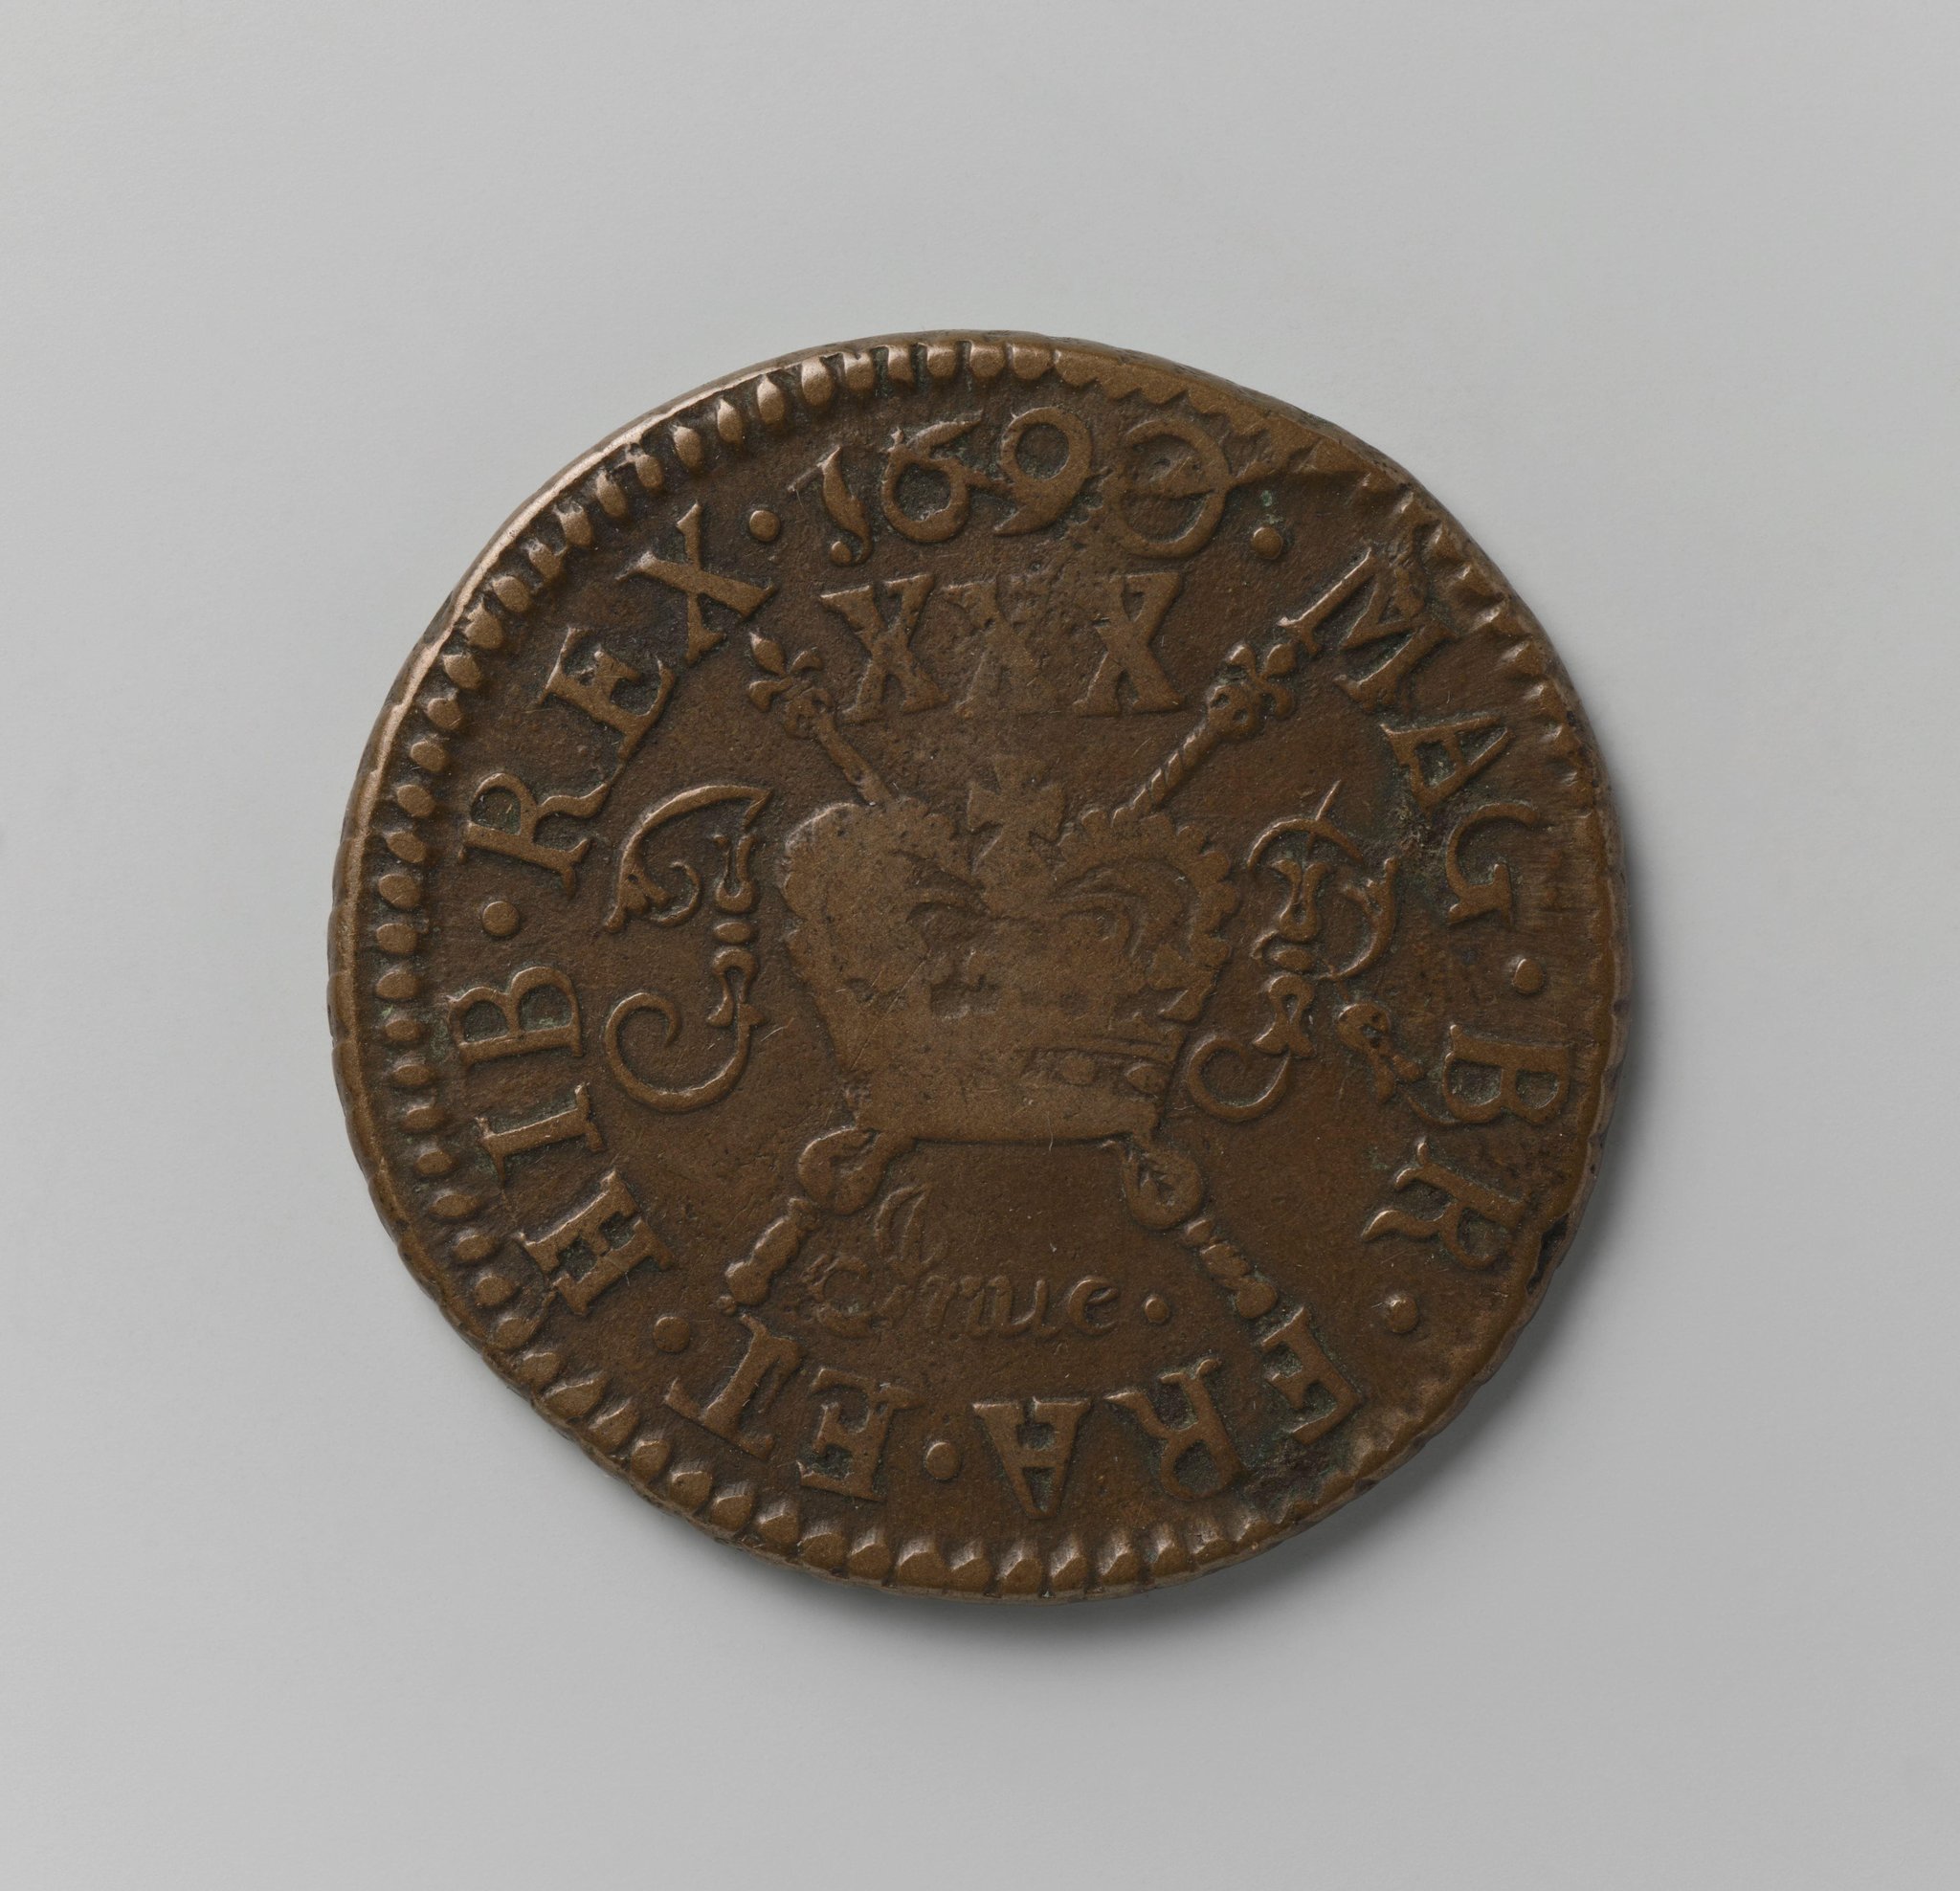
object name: coin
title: Ierland, Jacobus II, ½ crown, juni [jnue!] 1690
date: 1690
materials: bronze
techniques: striking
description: Bronzen munt. Voorzijde: gelauwerd hoofd van de vorst naar links. Keerzijde: tussen letters J en R kroon op twee gekruiste scepters.Jaartal bovenaan in omschrift, maand-aanduiding onder kroon, Waarde-aanduiding XXX [pence] boven kroon. Bloemrand. Gun-money.